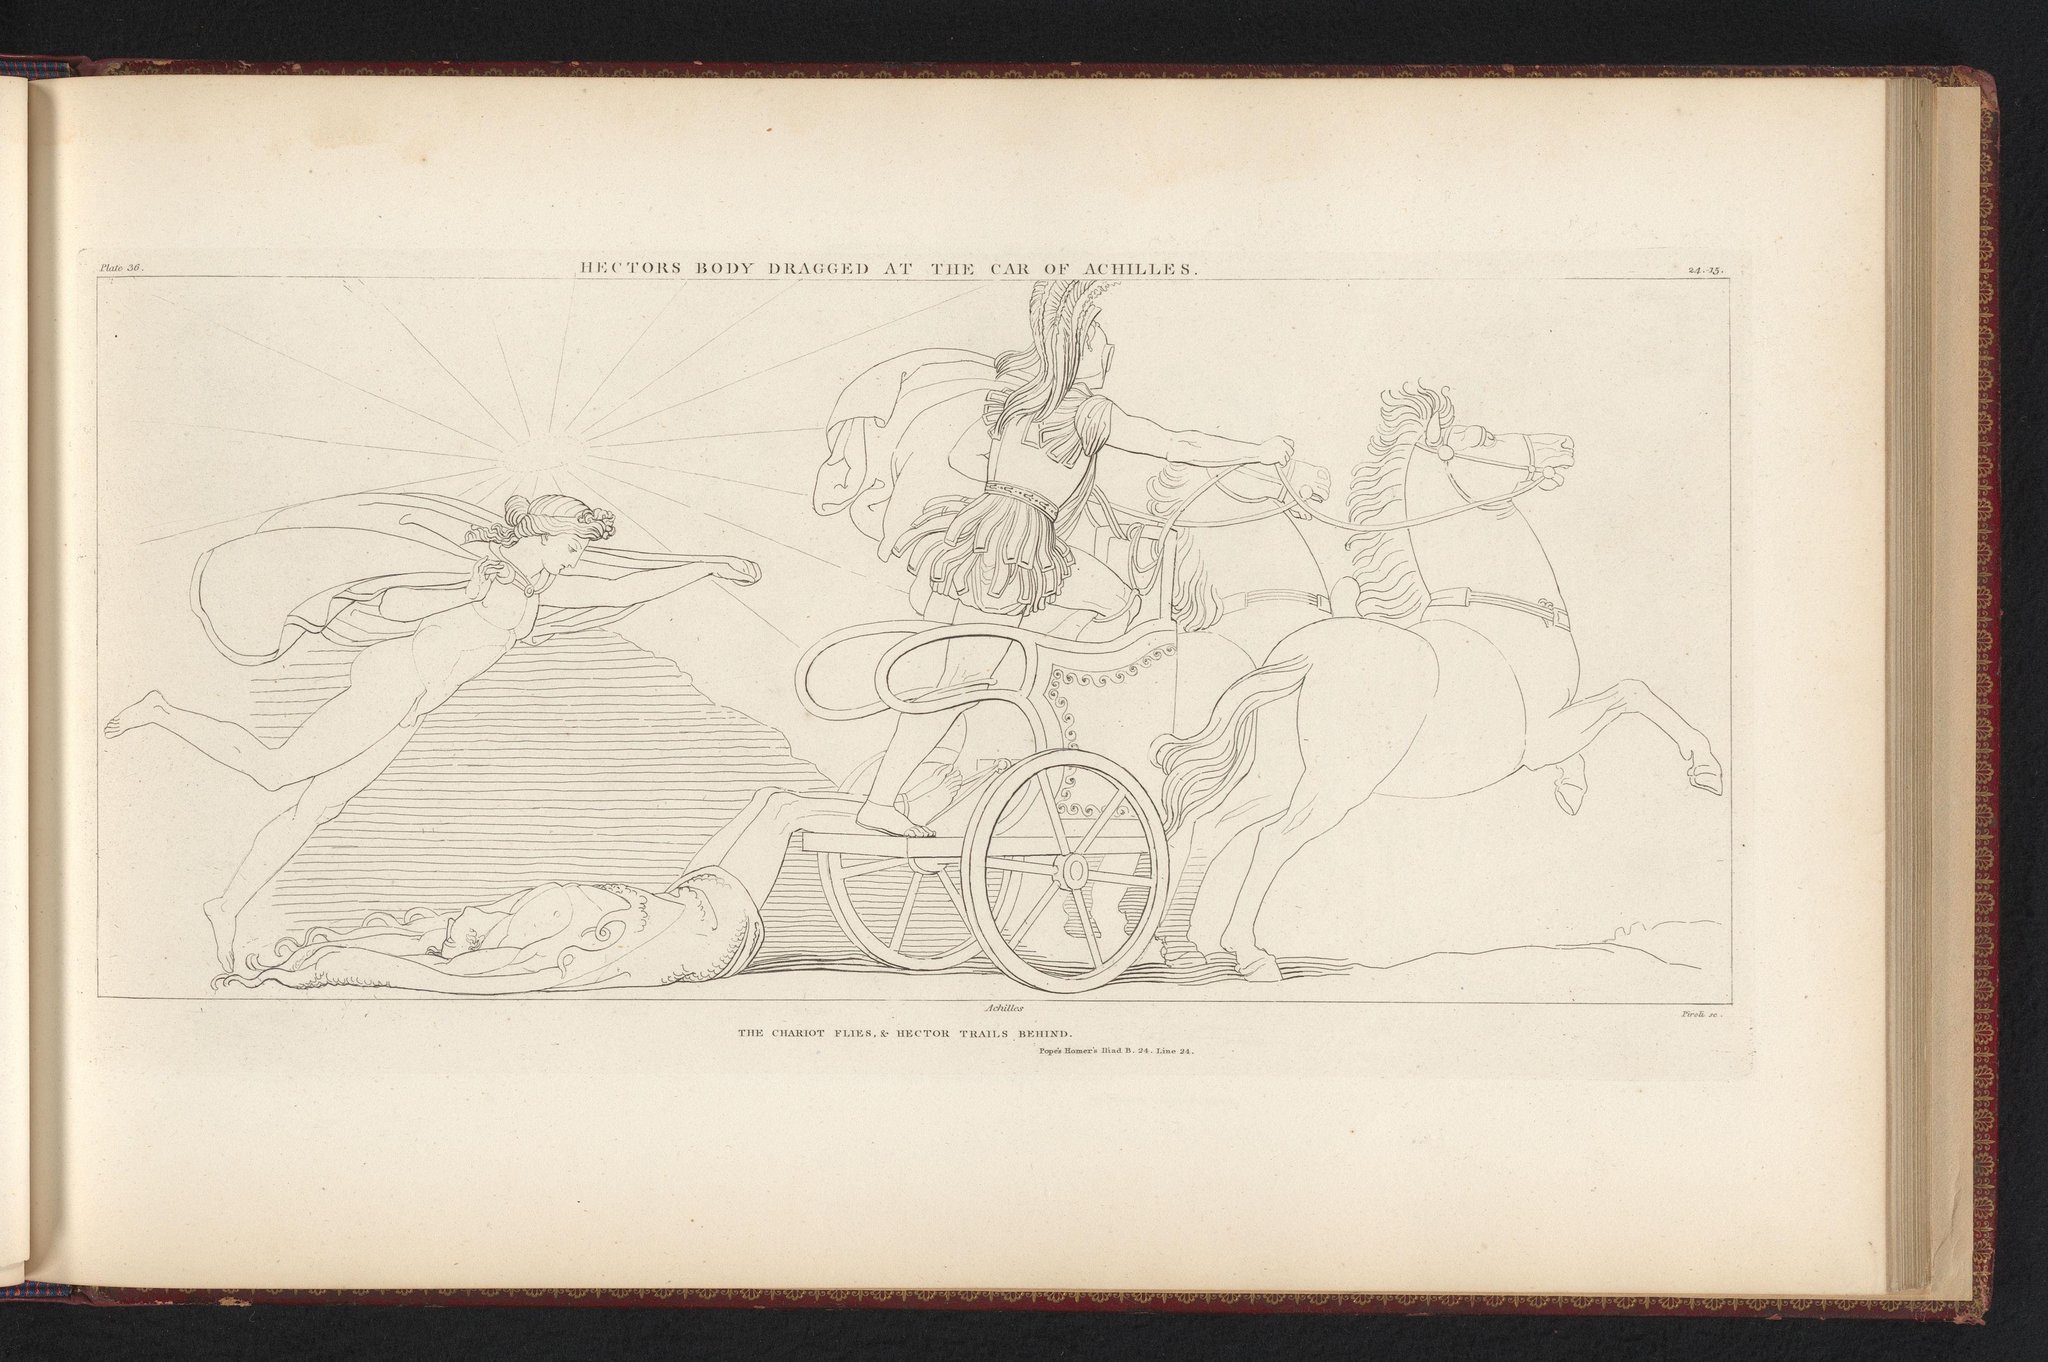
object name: print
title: Achilles met lijk van Hector achter zijn zegewagen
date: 1805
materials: paper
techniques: etching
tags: hector's body, tied to achilles' chariot, is dragged around the city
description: Prent maakt onderdeel uit van een serie met 39 prenten over de Ilias, geschreven door Homerus.